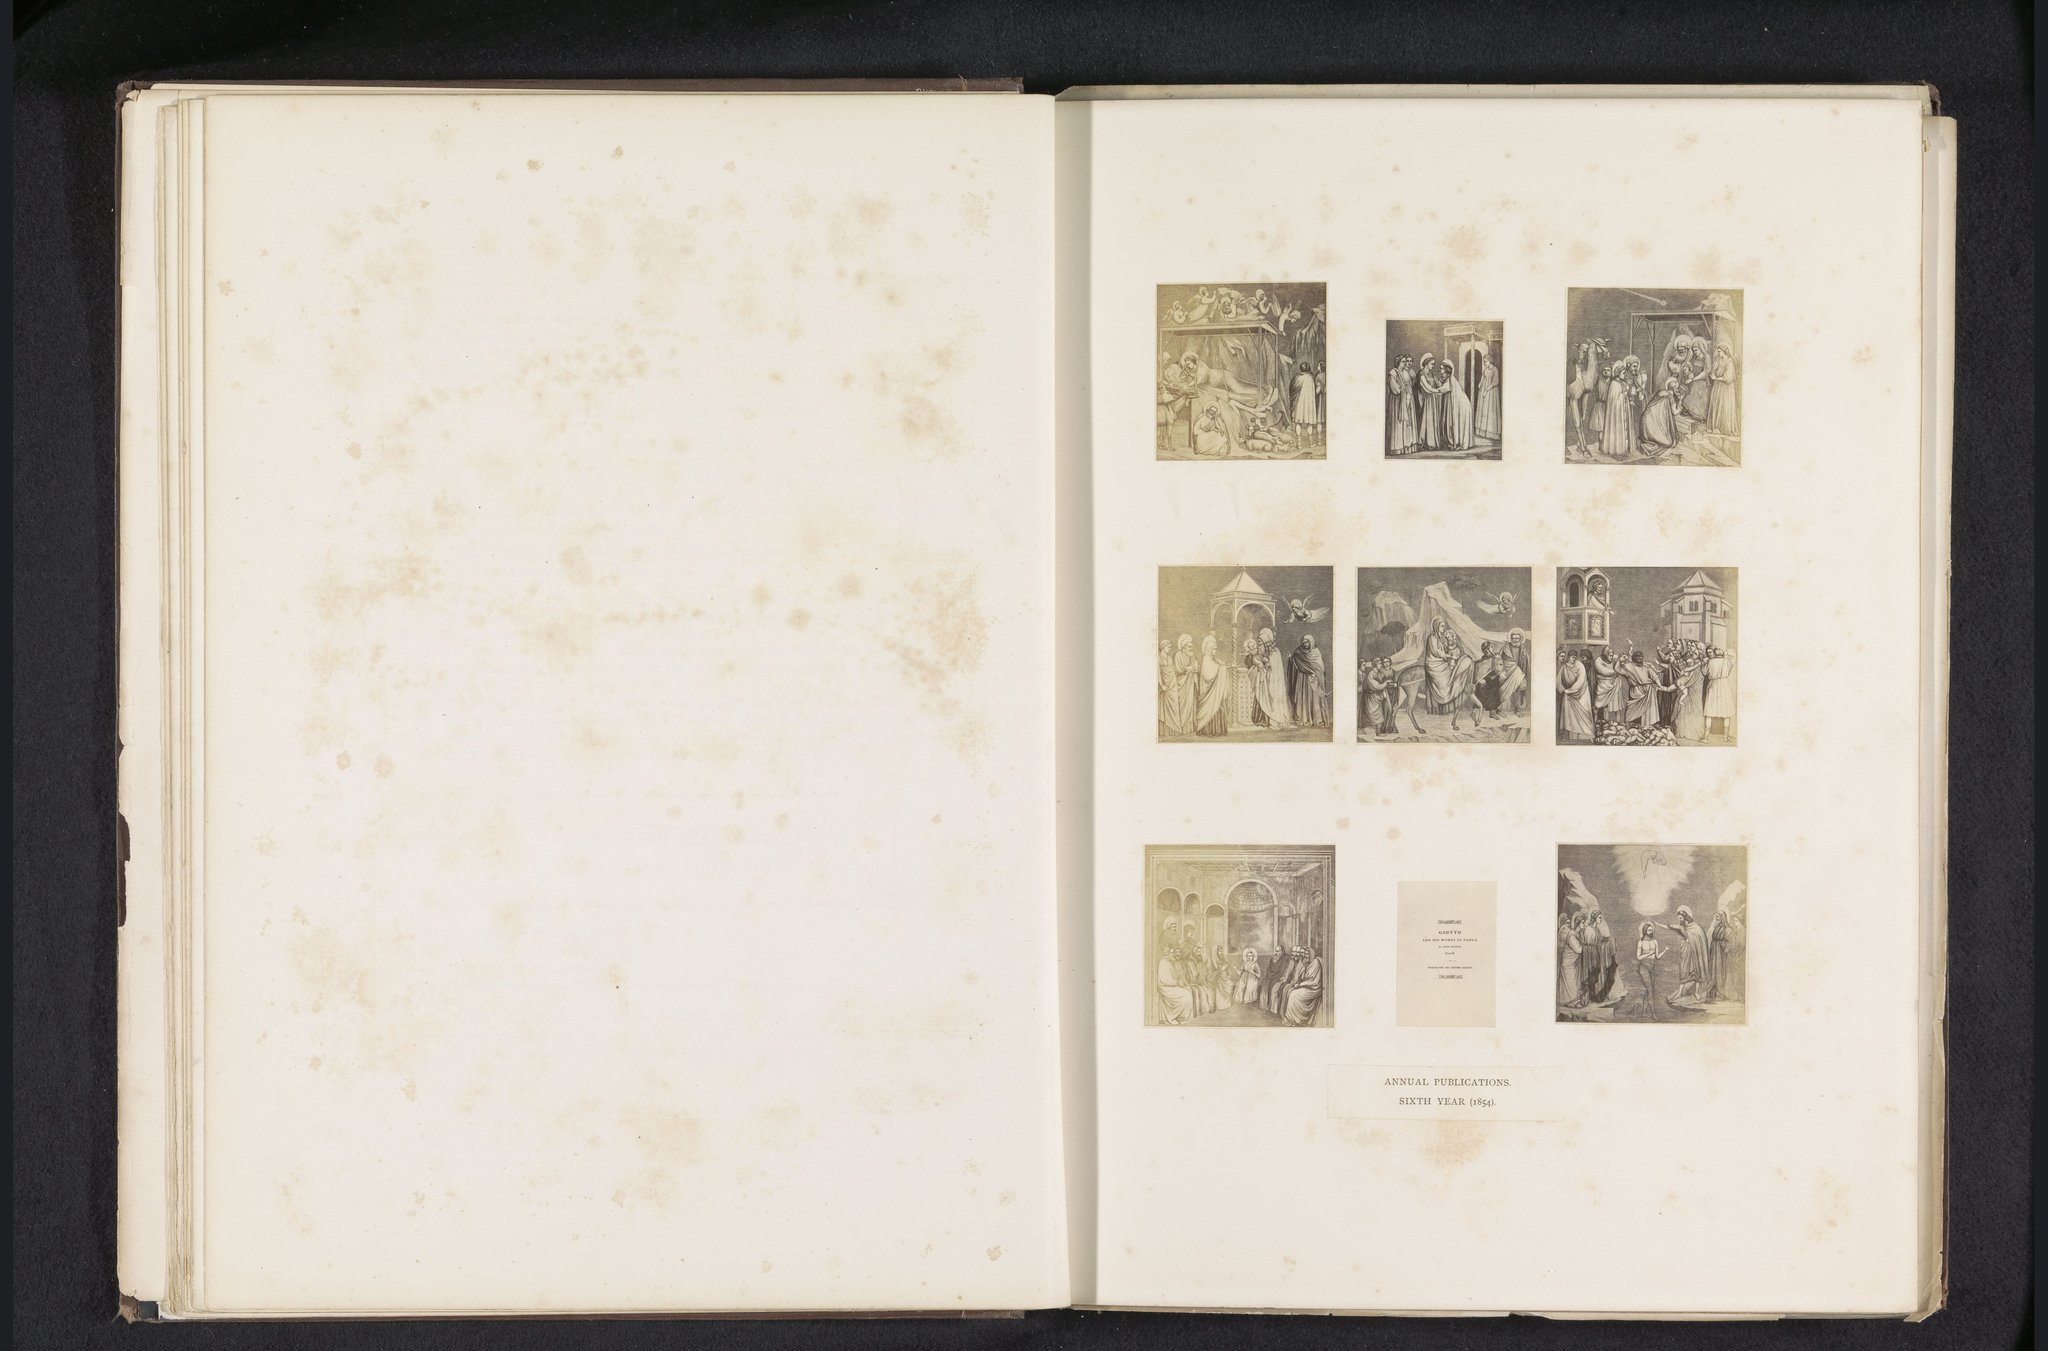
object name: reproduction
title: Negen fotoreproducties van een publicatie door de Arundel Society met prenten naar Giotto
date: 1859-1869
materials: photographic support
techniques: albumen print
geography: italy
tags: book, illustration ~ printed matter, book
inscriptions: inscription: ‘Annual publications. (...) Annual publications. Sixth year (1854).’